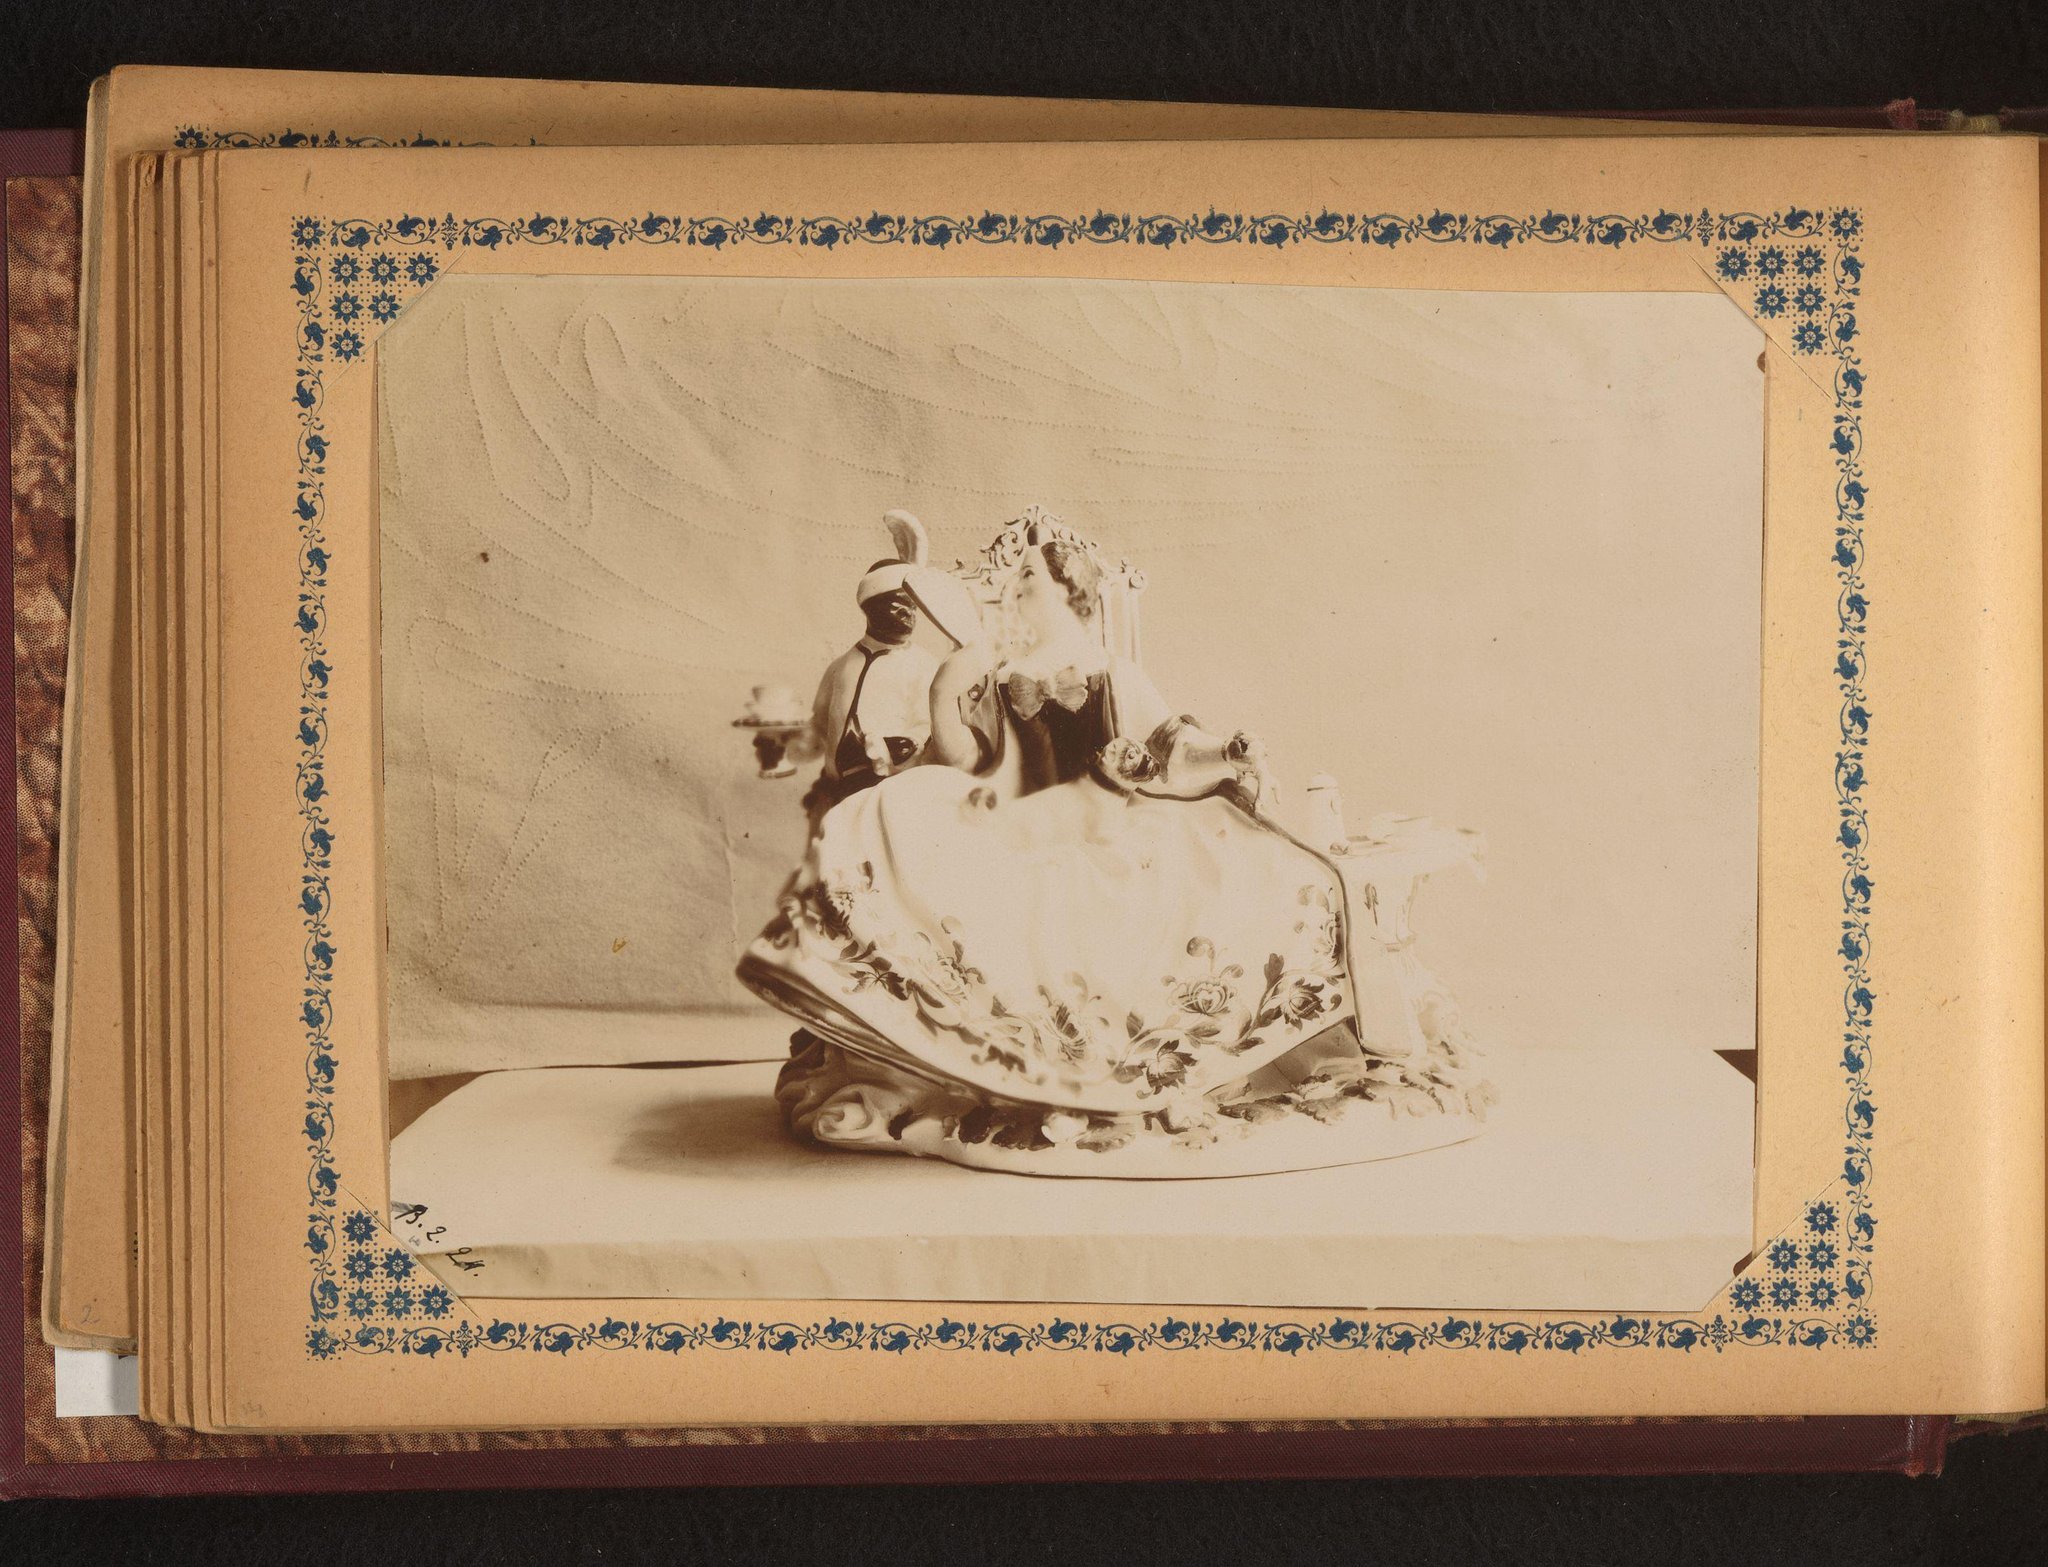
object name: photograph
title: Sculptuur van een zittende vrouw en een bediende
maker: Anonymous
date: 1880-1940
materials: cardboard, photographic support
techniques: gelatin silver print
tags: sitting figure - aa - female human figure, piece of sculpture, reproduction of a piece of sculpture, manservant, footman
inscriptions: number: ‘B. 2. 24.’